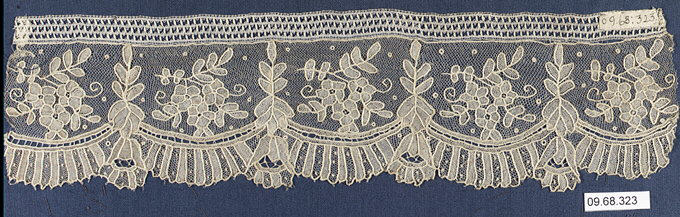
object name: specimen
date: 1801-1900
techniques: lace